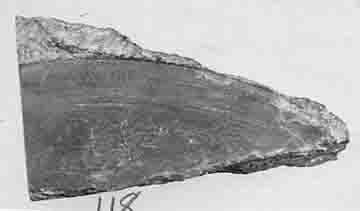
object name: fragment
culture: russian, siberia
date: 1902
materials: jade